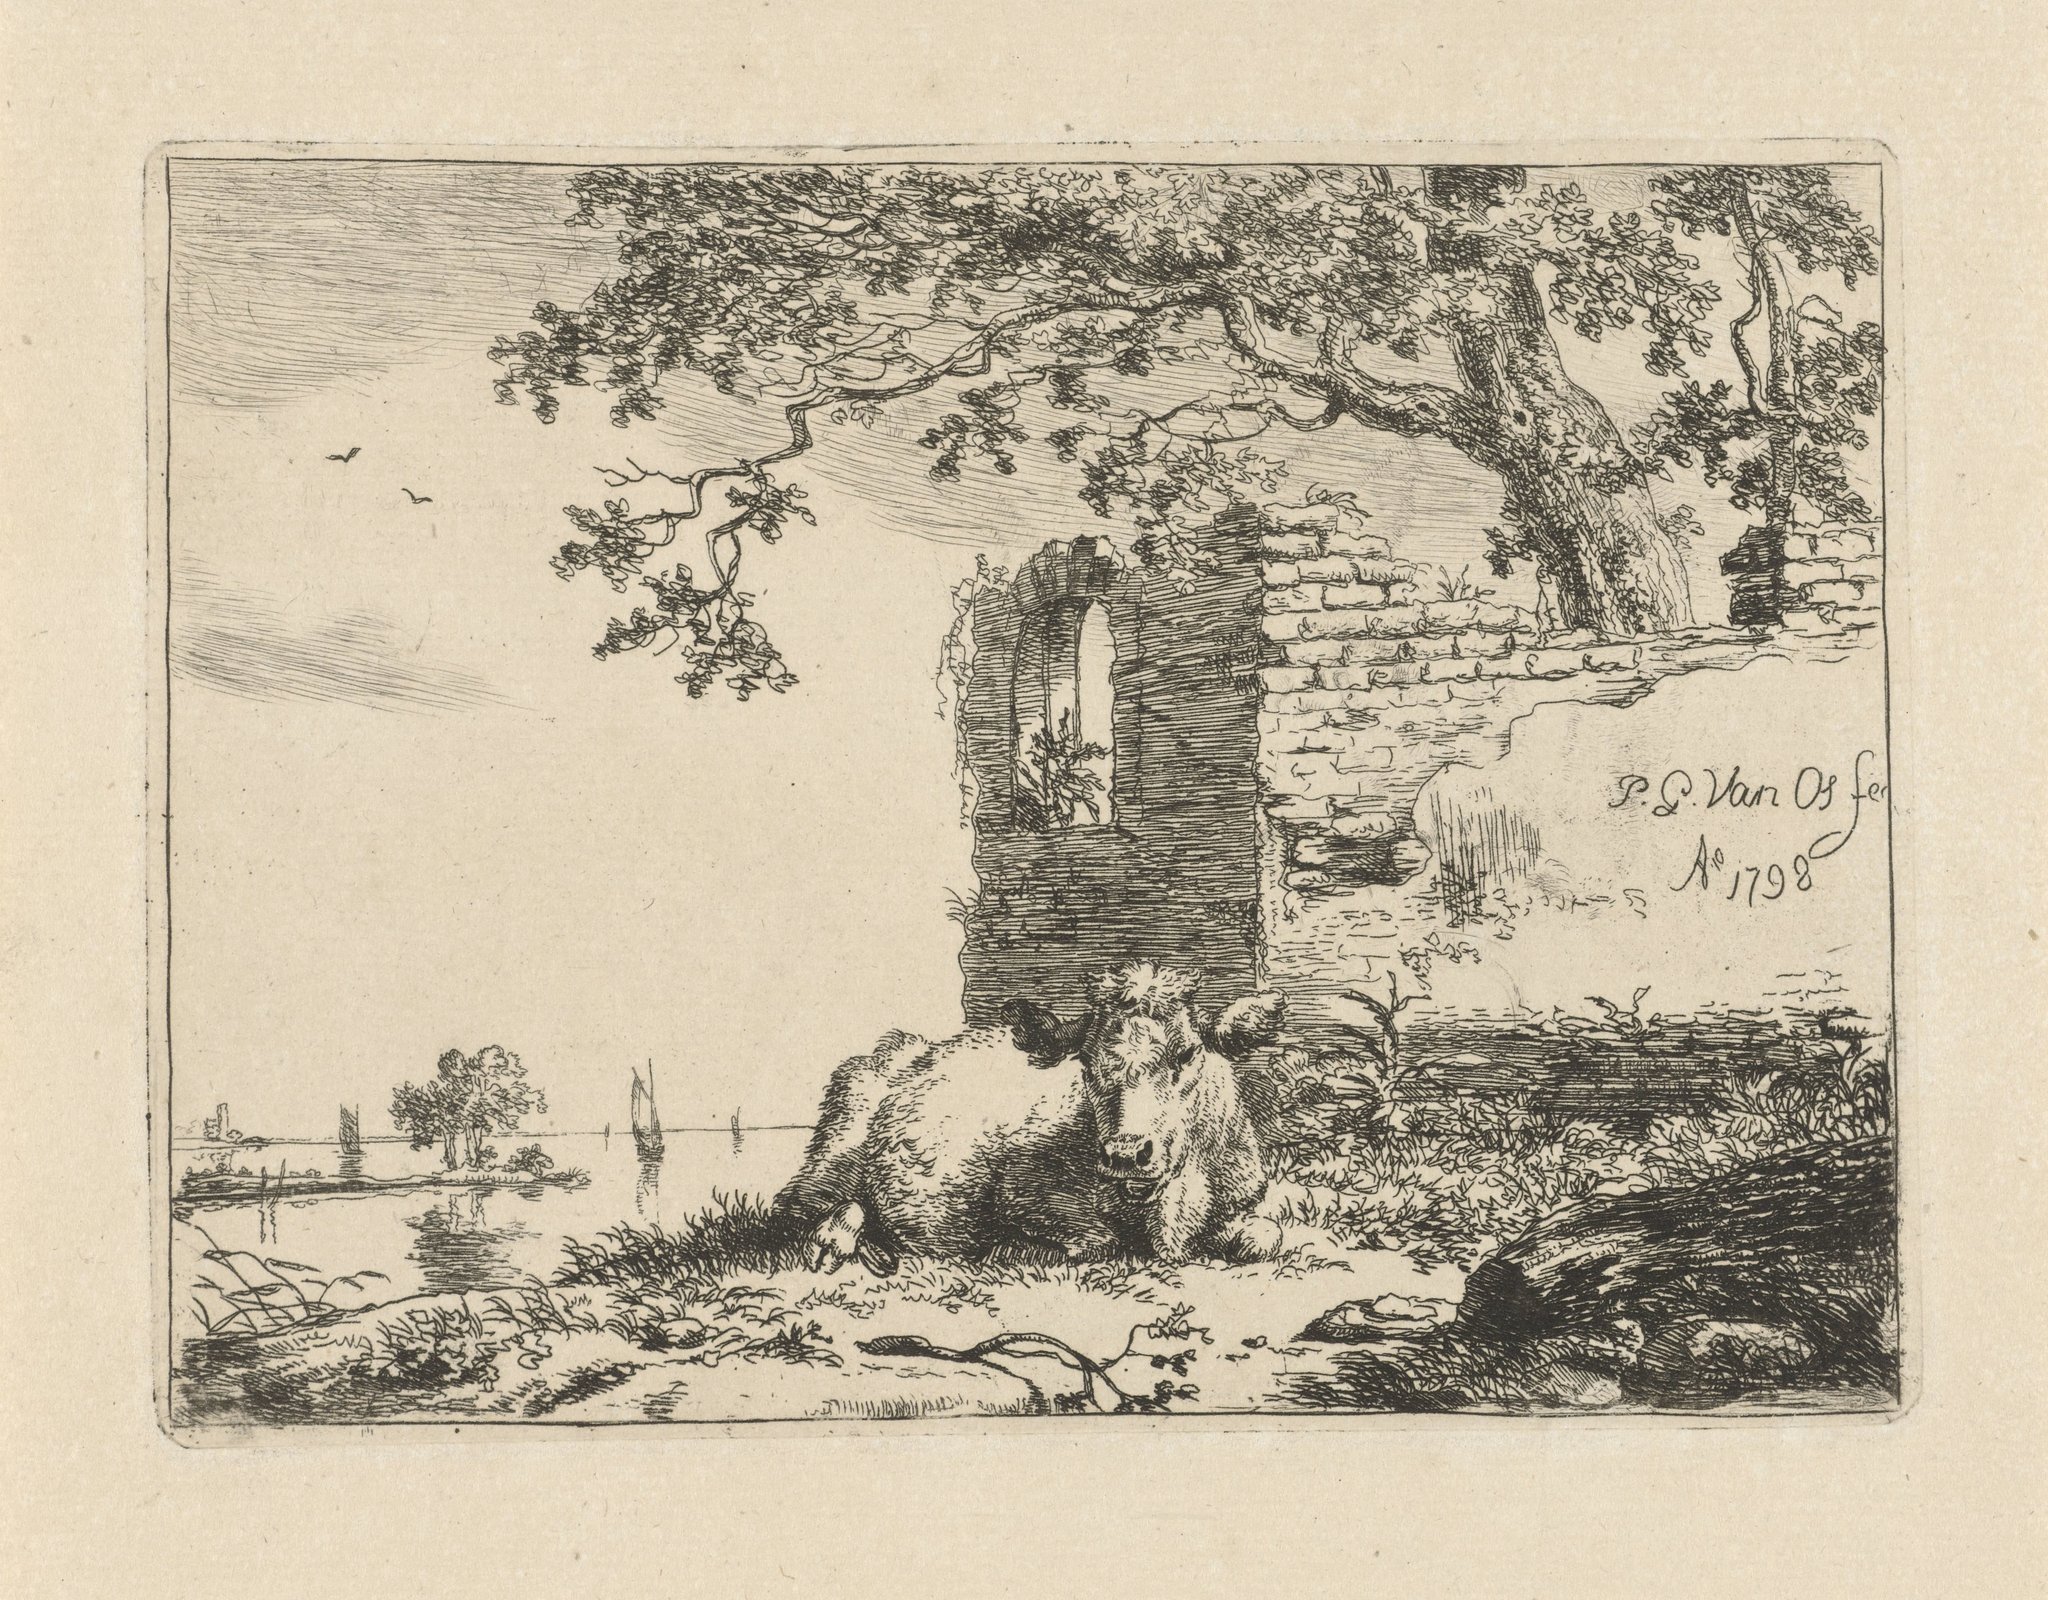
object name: print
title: Liggend kalf voor een ruïne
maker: pieter gerardus van os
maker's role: draughtsman, painter, print maker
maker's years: 1776-1839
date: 1798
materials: paper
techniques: etching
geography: netherlands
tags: calf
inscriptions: collector's mark: Lugt 2228